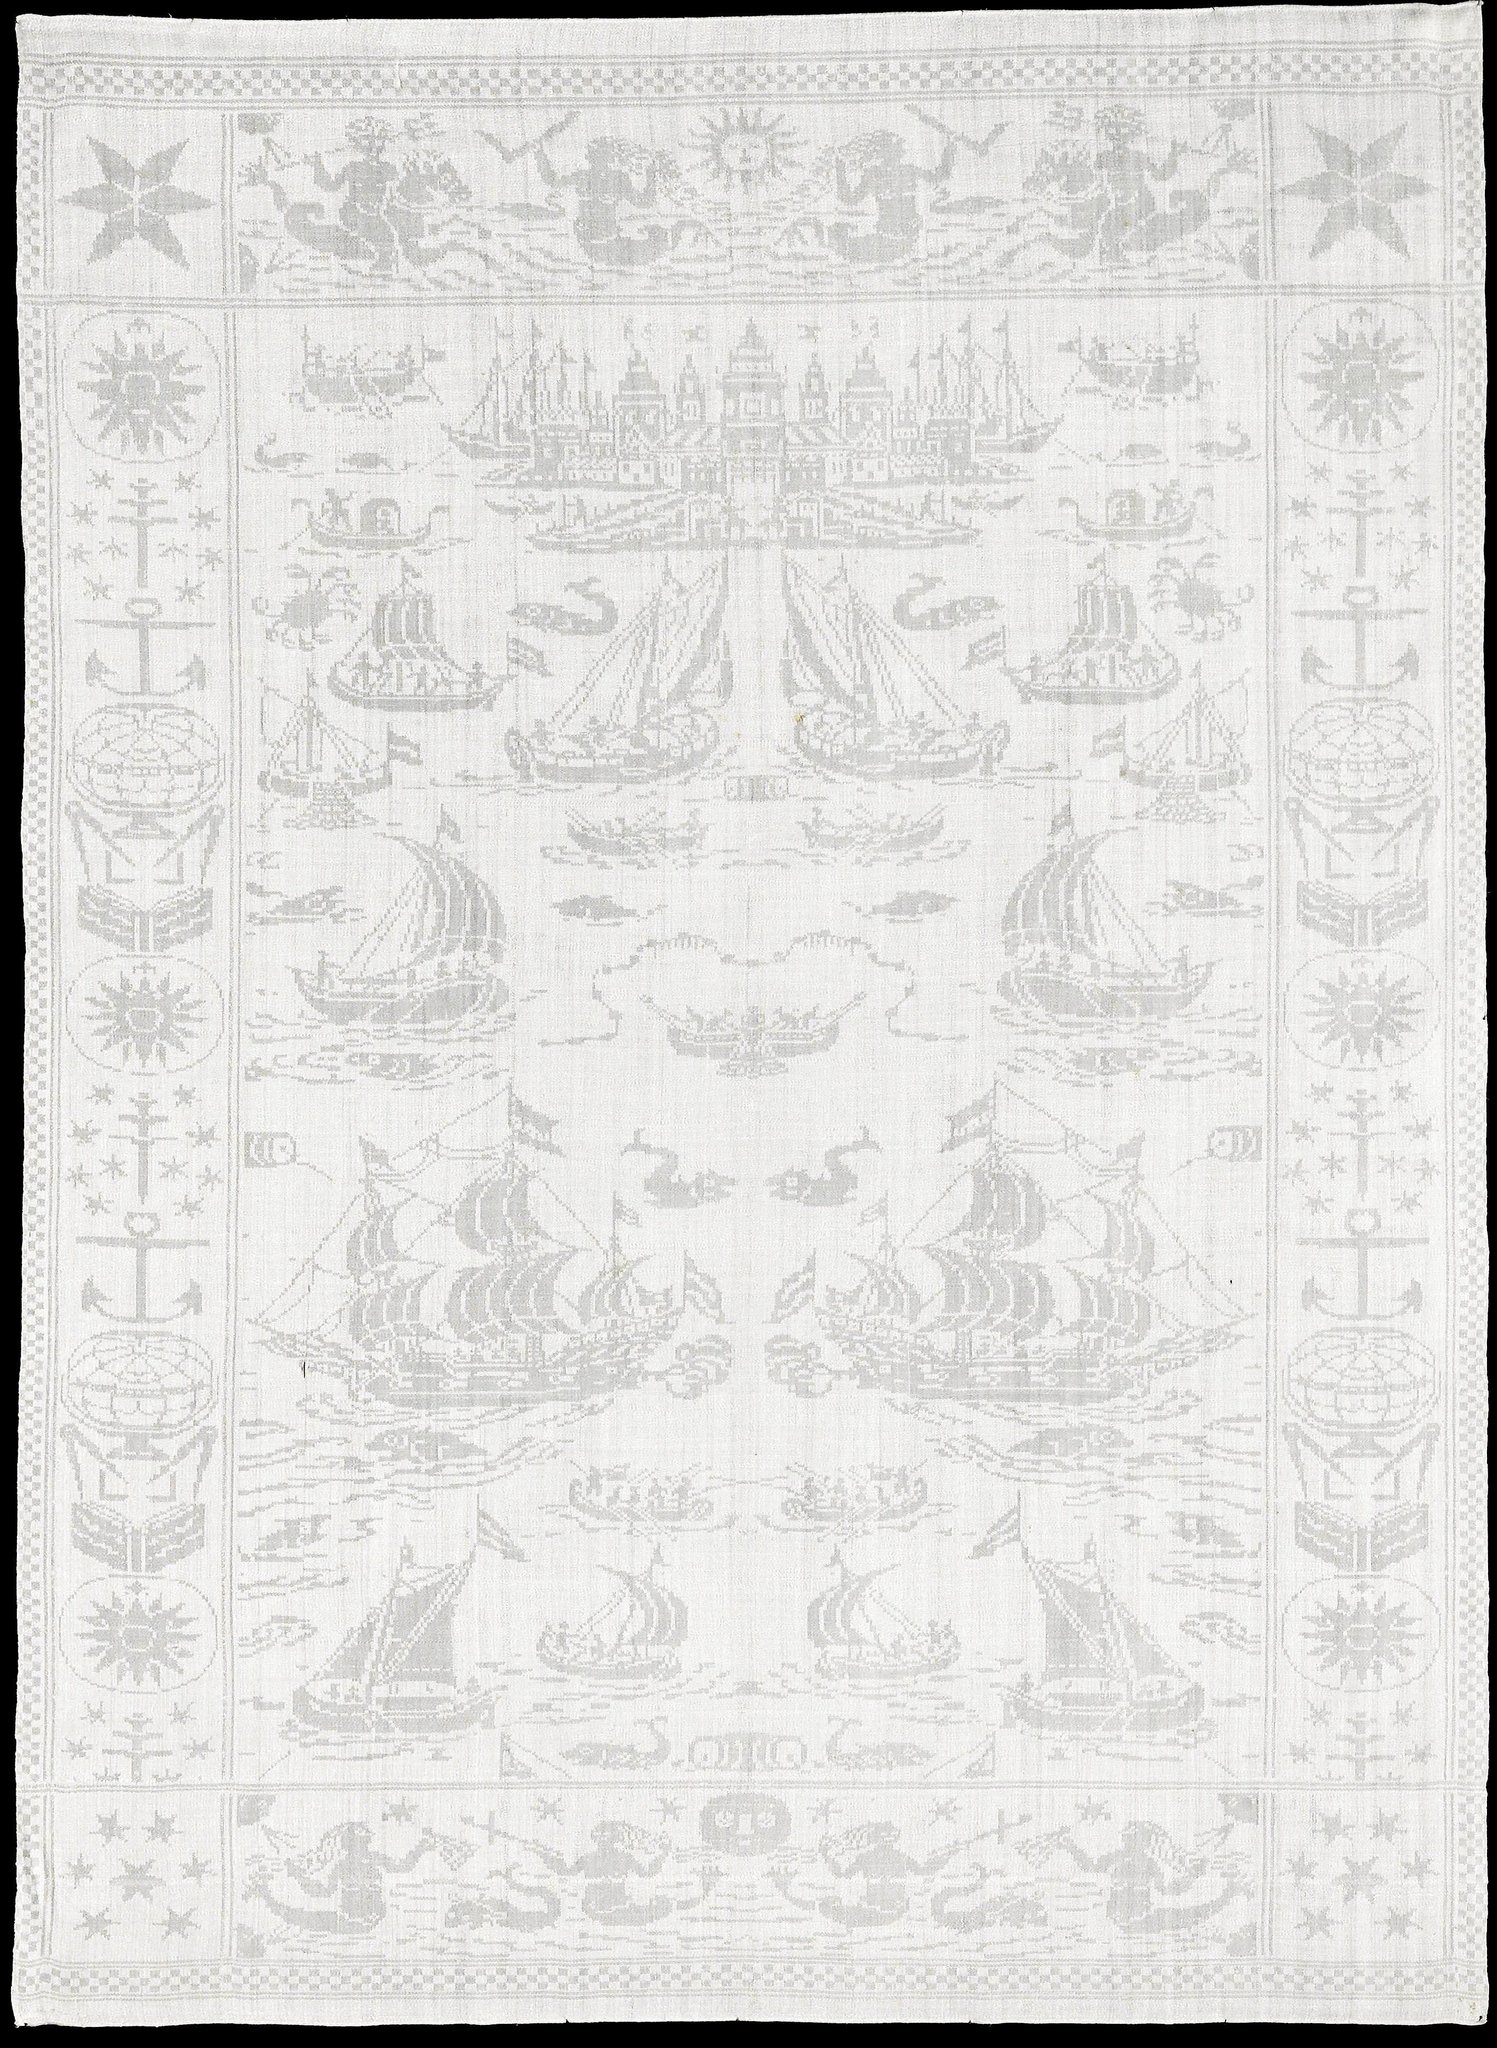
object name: napkin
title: Servet met een profiel van een havenstad en diverse schepen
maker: Anonymous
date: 1600-1649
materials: linen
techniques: damask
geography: haarlem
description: Servet van linnendamast met een havenstad en diverse schepen, waaronder beurtschepen, wijdschepen, walvissloep, gondel en pinas. Staande en liggende randen: allegorische voorstellingen van de scheepvaart bij dag en bij nacht en nautische instrumenten als kompasroos, jacobsstaf, anker, hemelglobe, passers, quadrant, boek (journaal?), sterrebeeld.